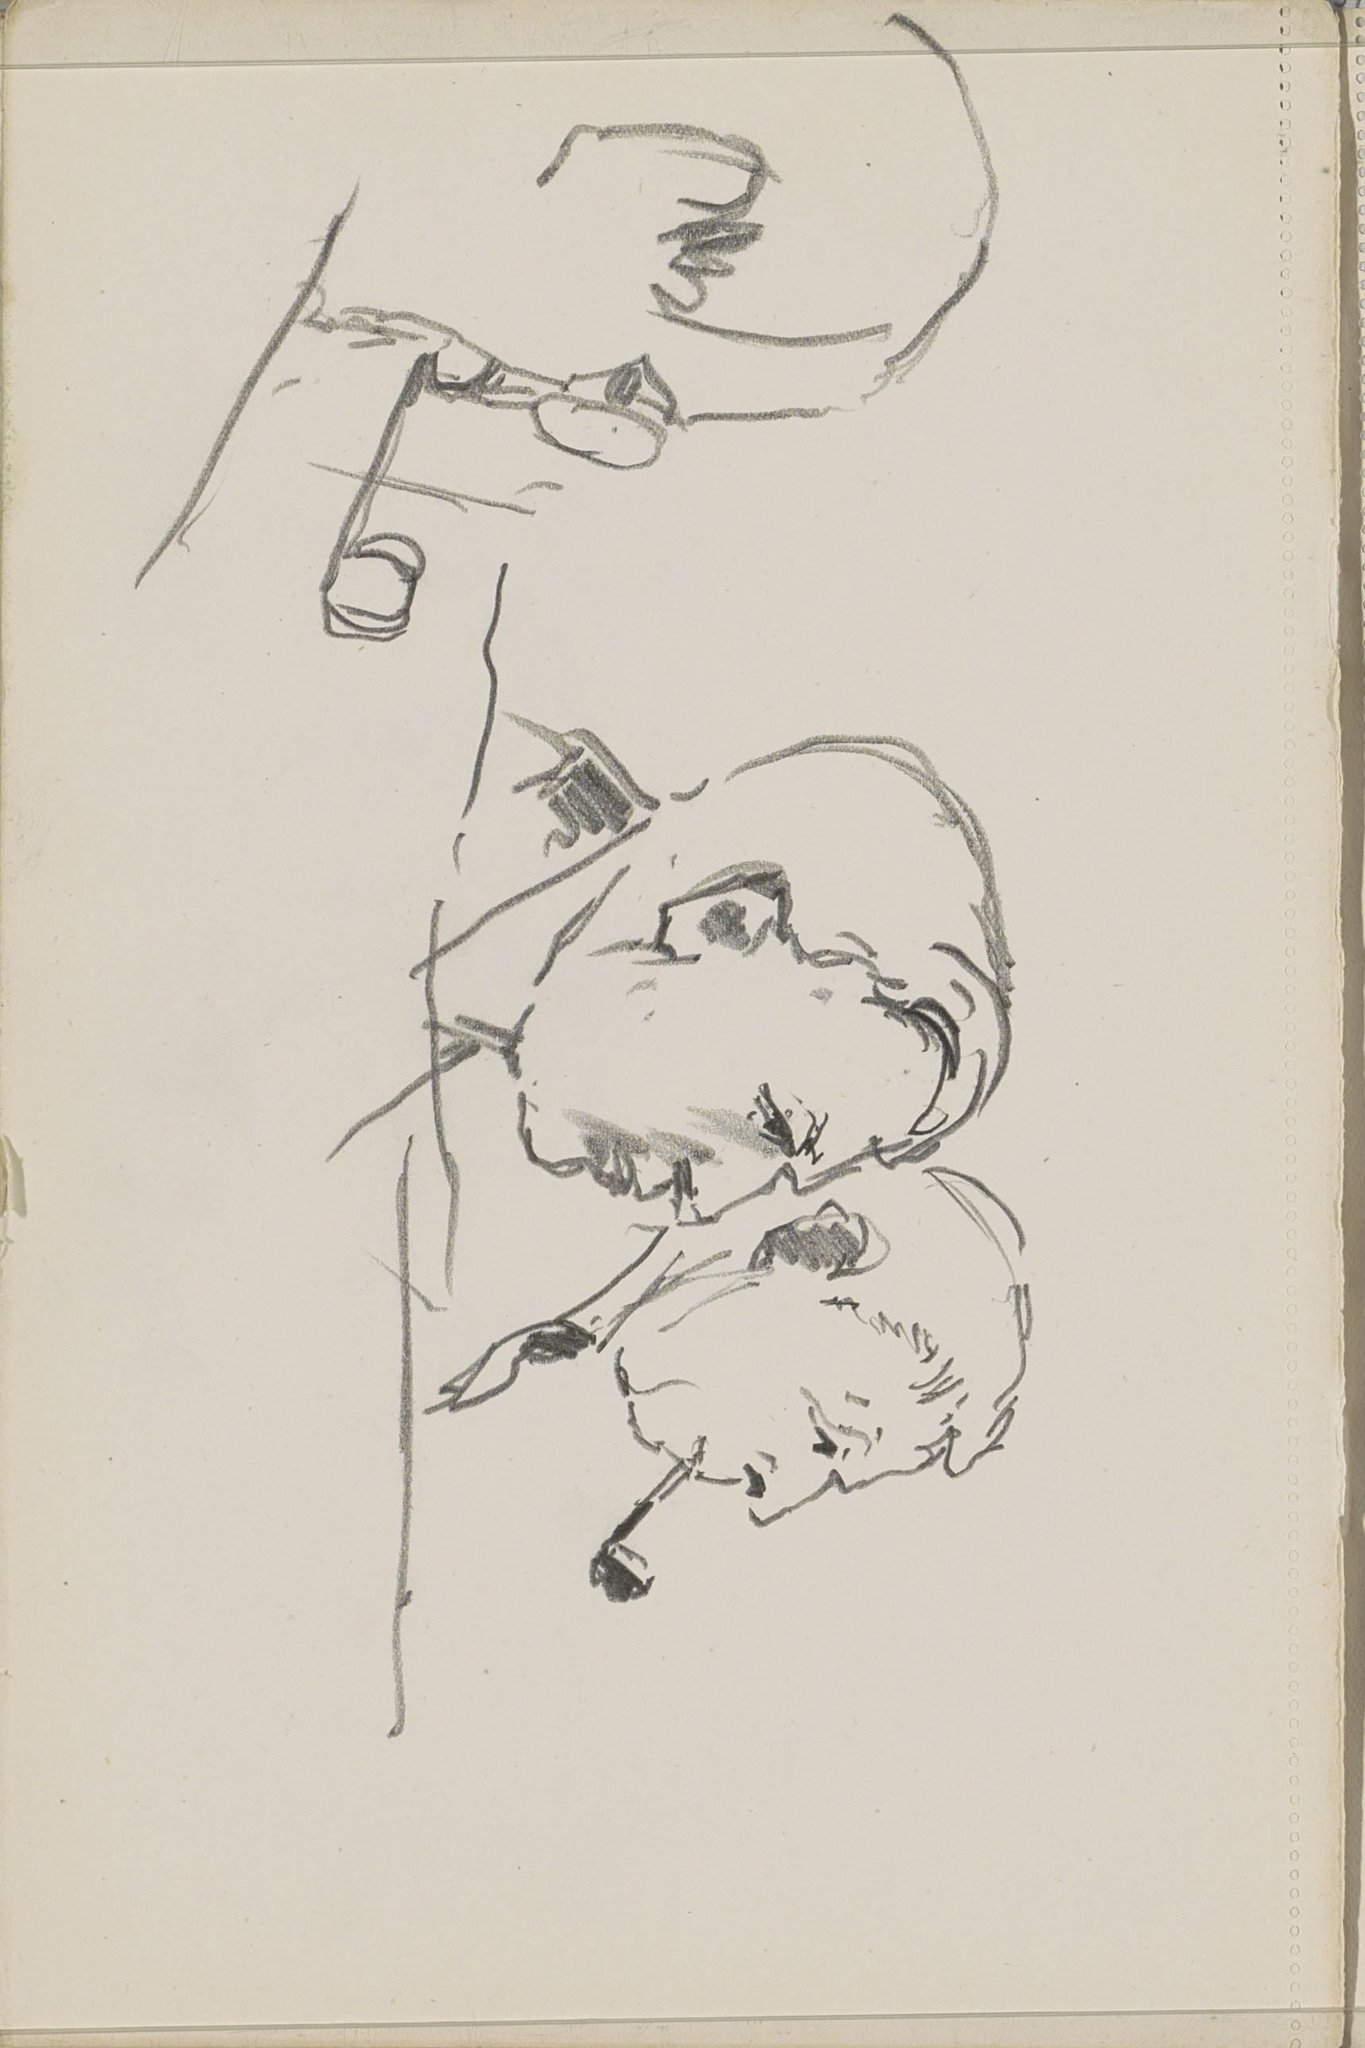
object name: sketchbook leaf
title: Drie mannen, van wie er twee een pijp roken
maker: cornelis vreedenburgh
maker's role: draughtsman, print maker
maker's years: 1880-1946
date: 1890-1946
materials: paper, pencil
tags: head (human), pipe ~ tobacco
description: Blad 53 verso uit een schetsboek met 61 bladen.